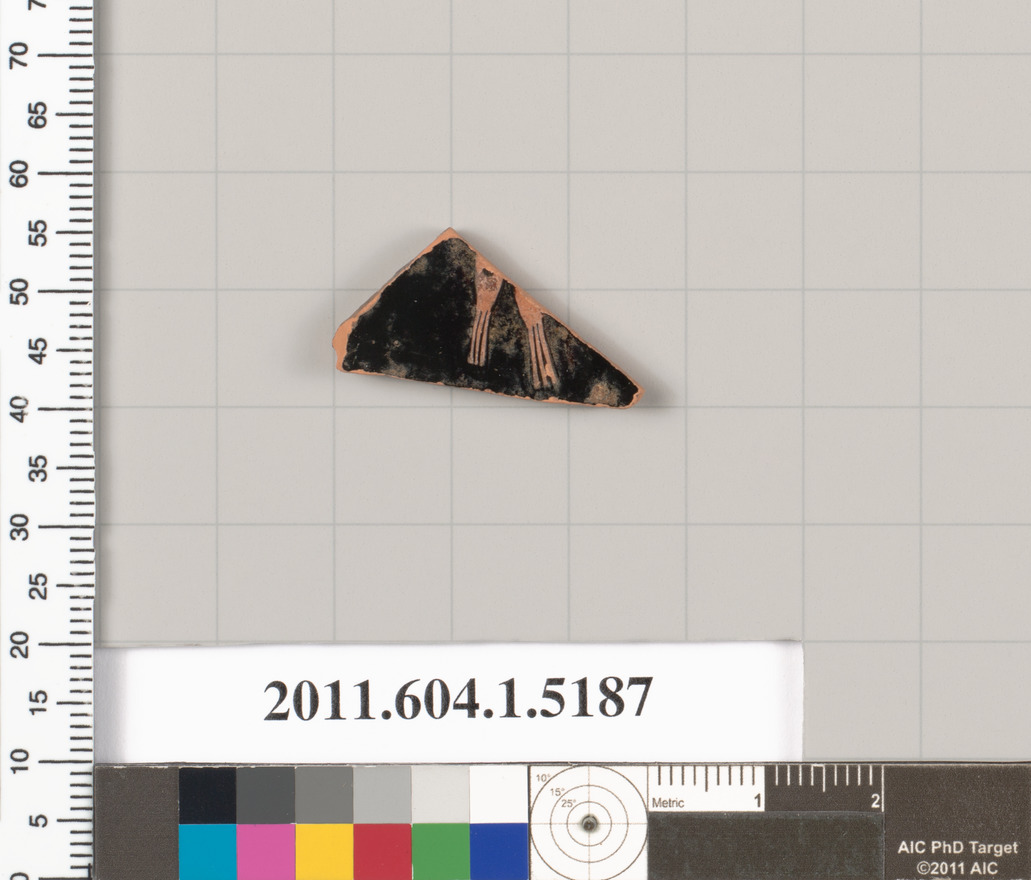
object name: kylix fragment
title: Terracotta fragment of a kylix (drinking cup)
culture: greek, attic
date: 500-480 BCE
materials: terracotta